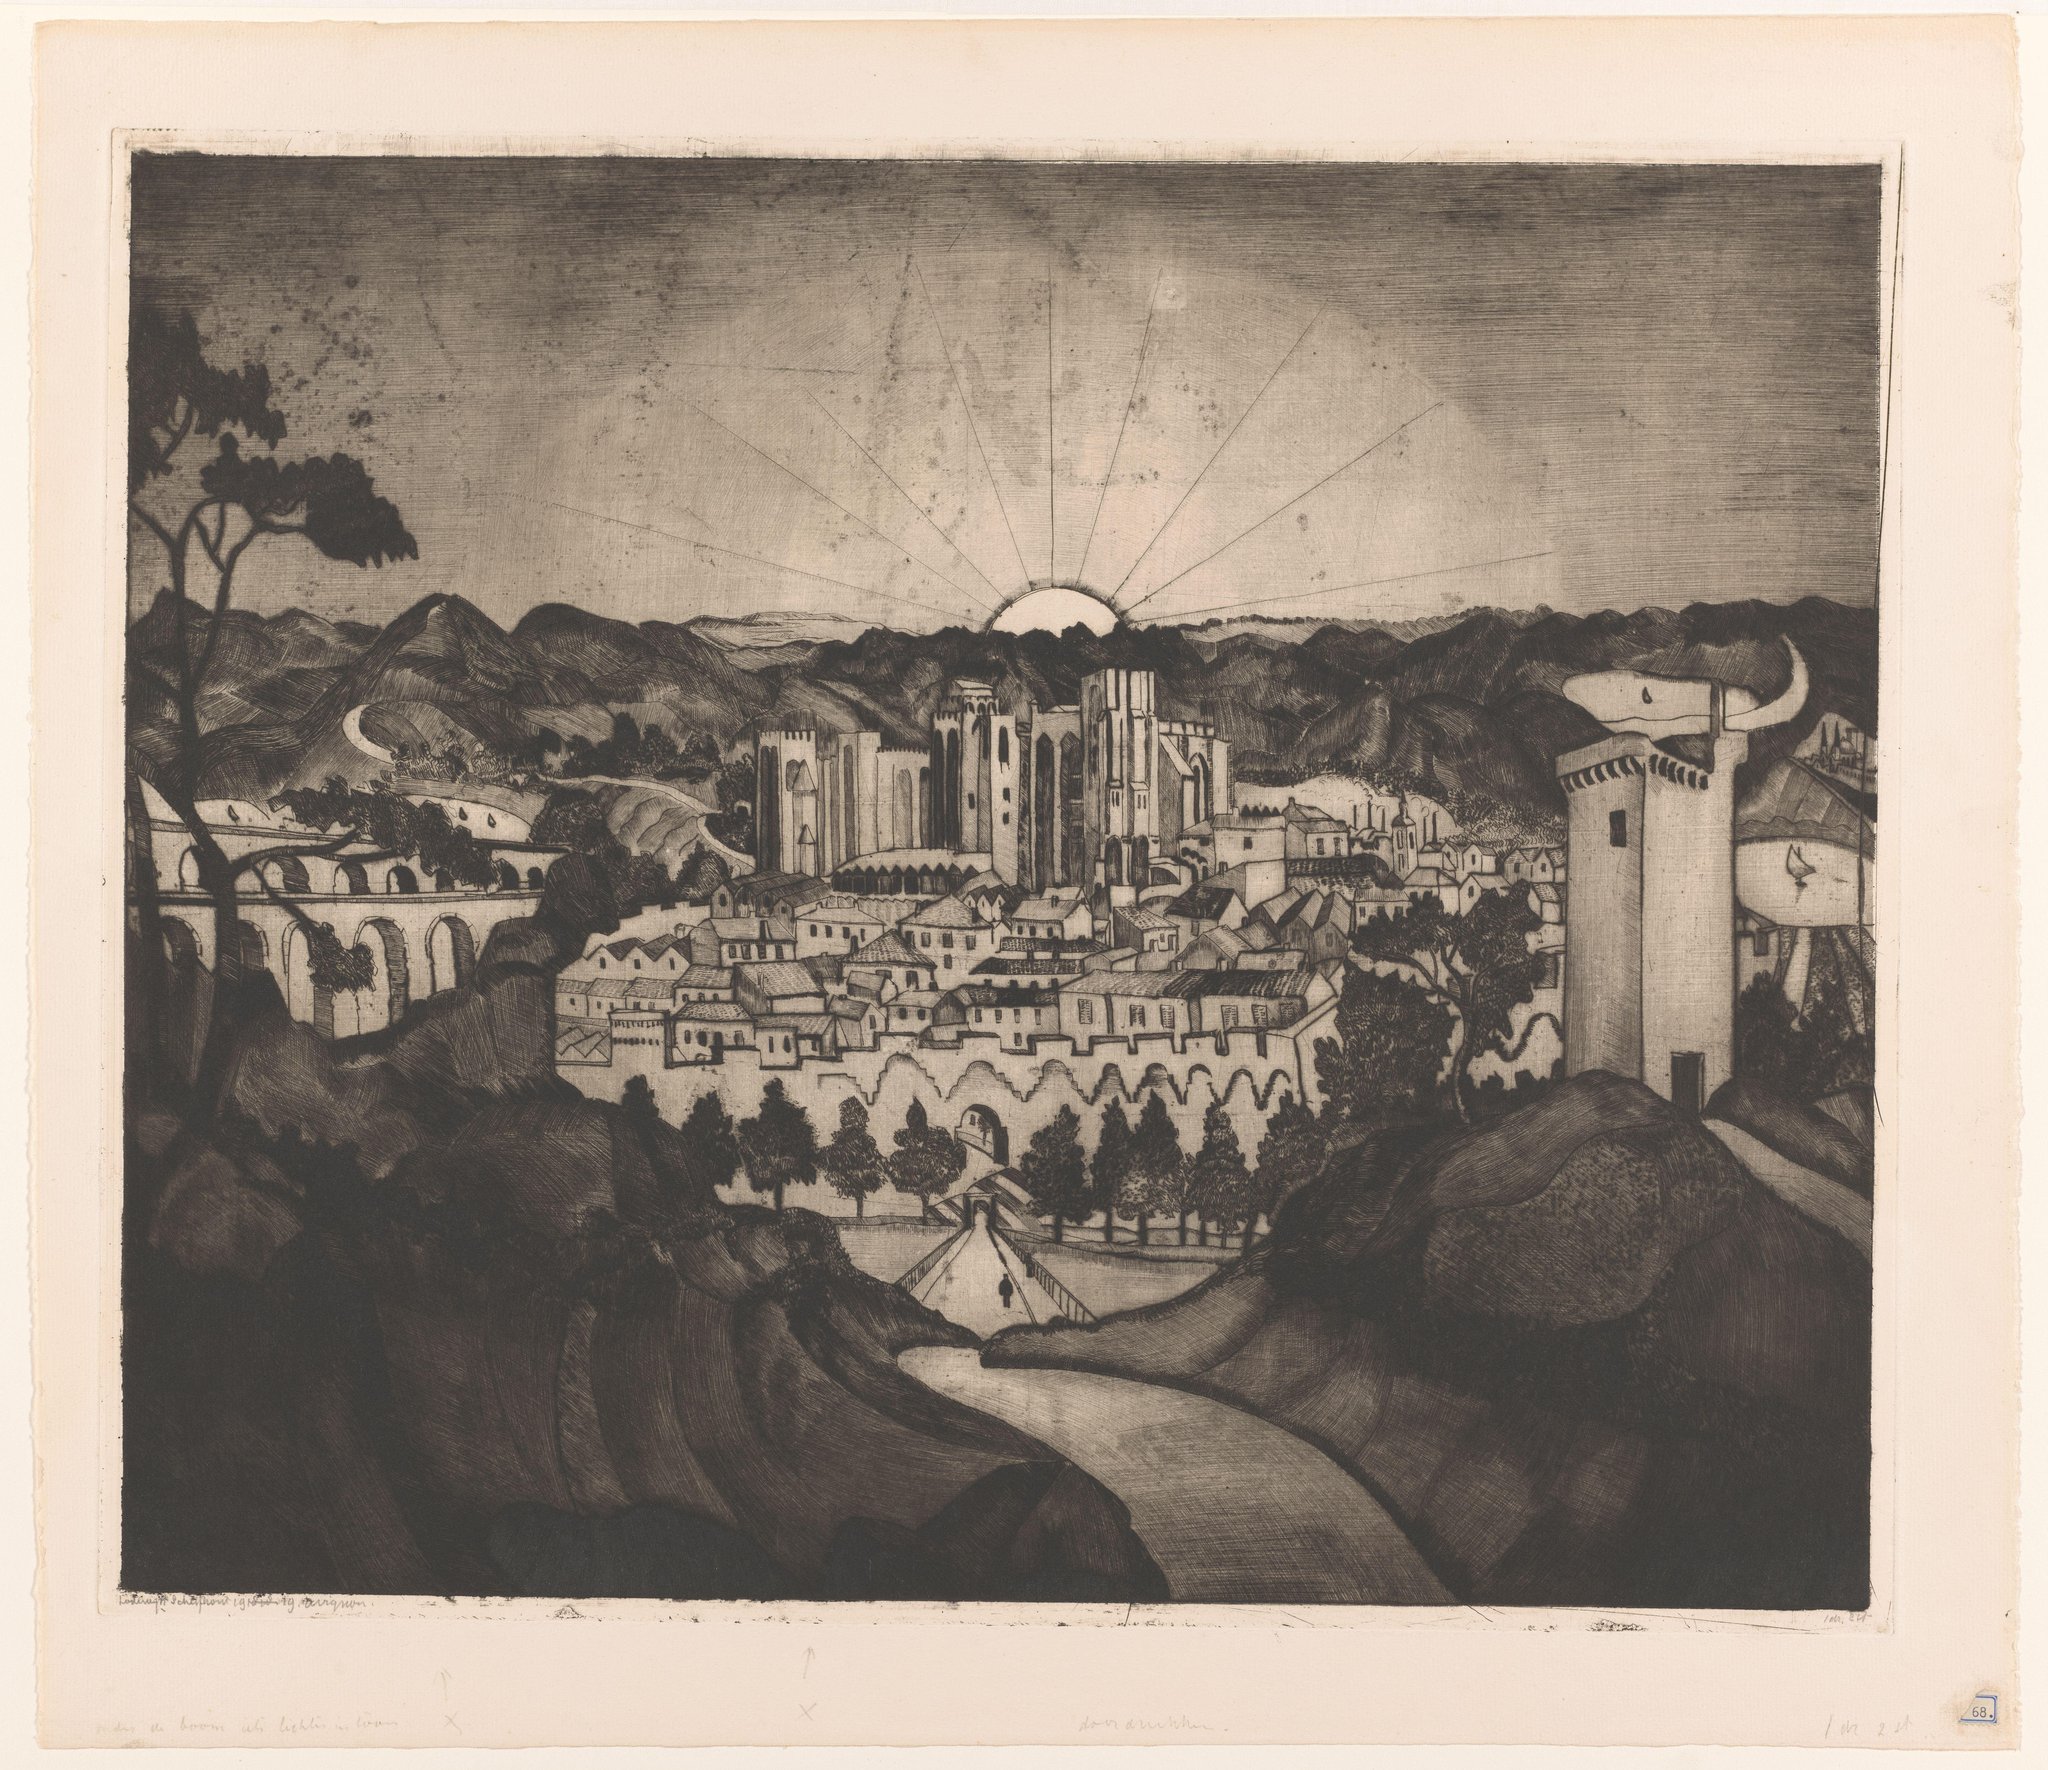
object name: print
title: Avignon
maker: lodewijk schelfhout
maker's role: draughtsman, print maker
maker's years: 1881-1943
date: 1918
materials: paper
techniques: drypoint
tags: city-view, and landscape with man-made constructions, sun as celestial body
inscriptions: collector's mark: Lugt 2228, collector's mark: Lugt 2760, inscription: ‘onder de boom iets lichter in toon / doordrukken’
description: De opgaande of ondergaande zon boven de stad Avignon in het zuiden van Frankrijk.